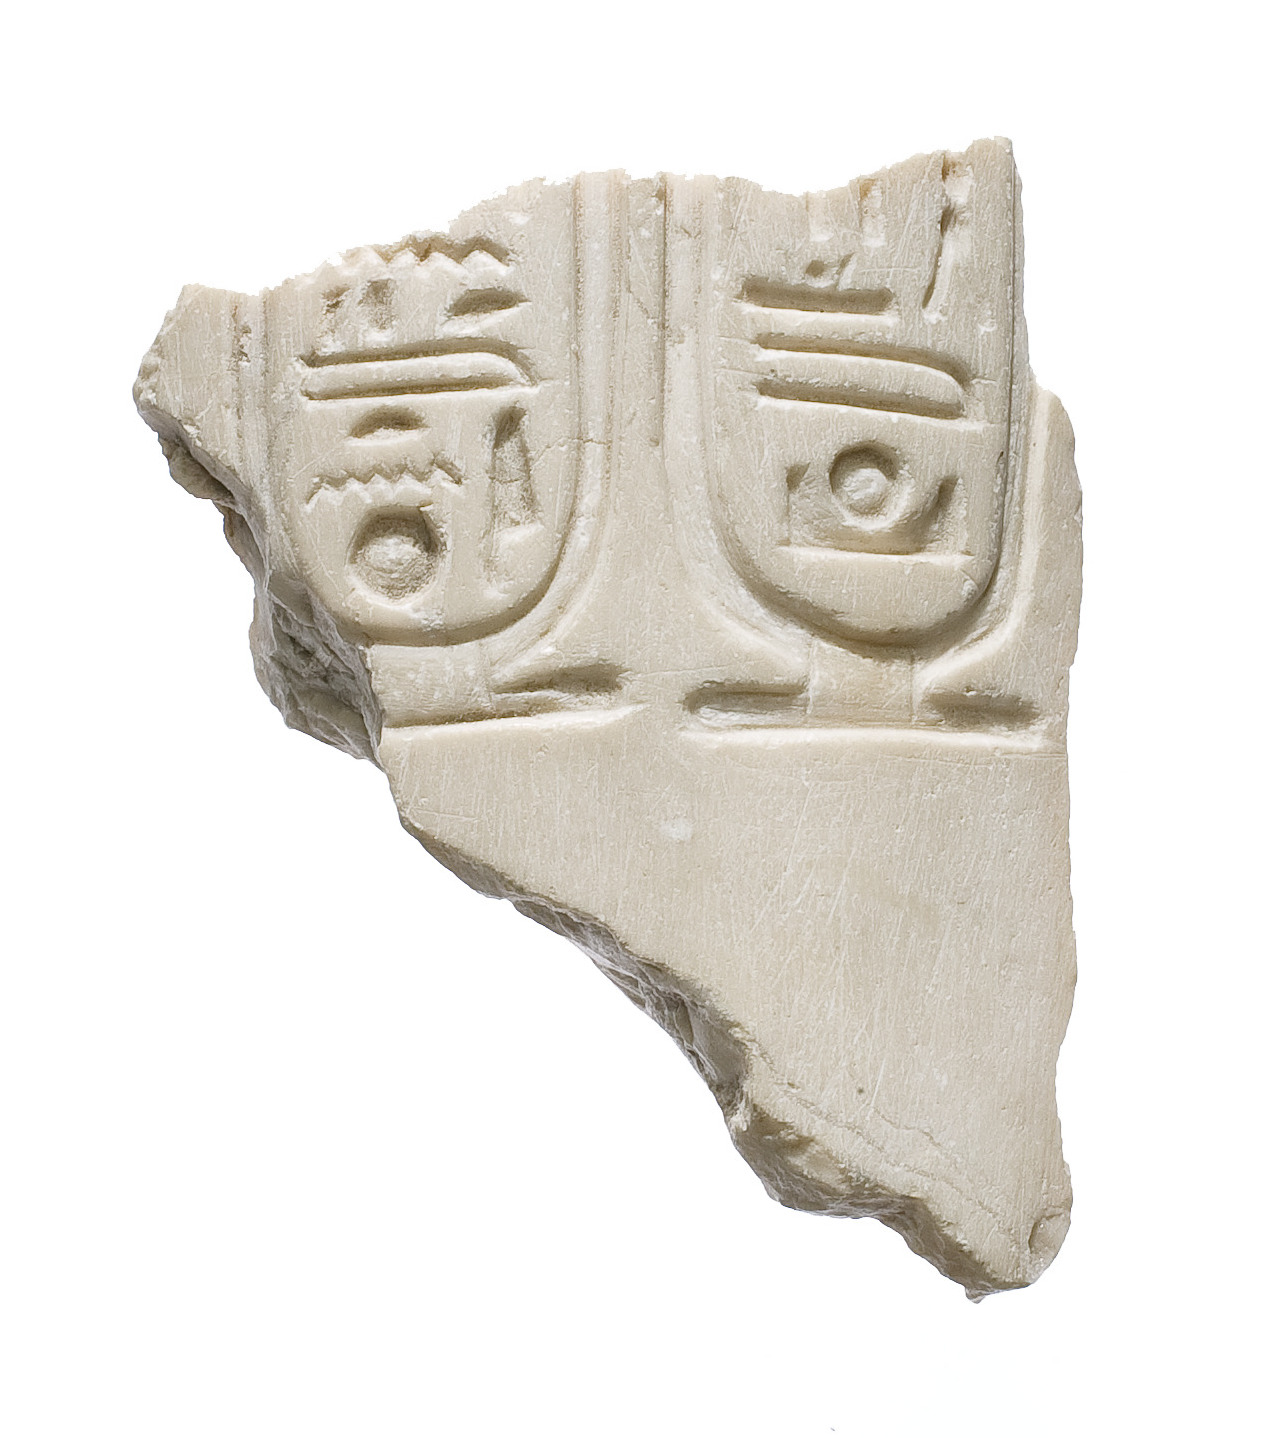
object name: arm at shoulder, aten cartouch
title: Arm at shoulder, Aten cartouches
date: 1353-1336 BCE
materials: limestone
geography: egypt